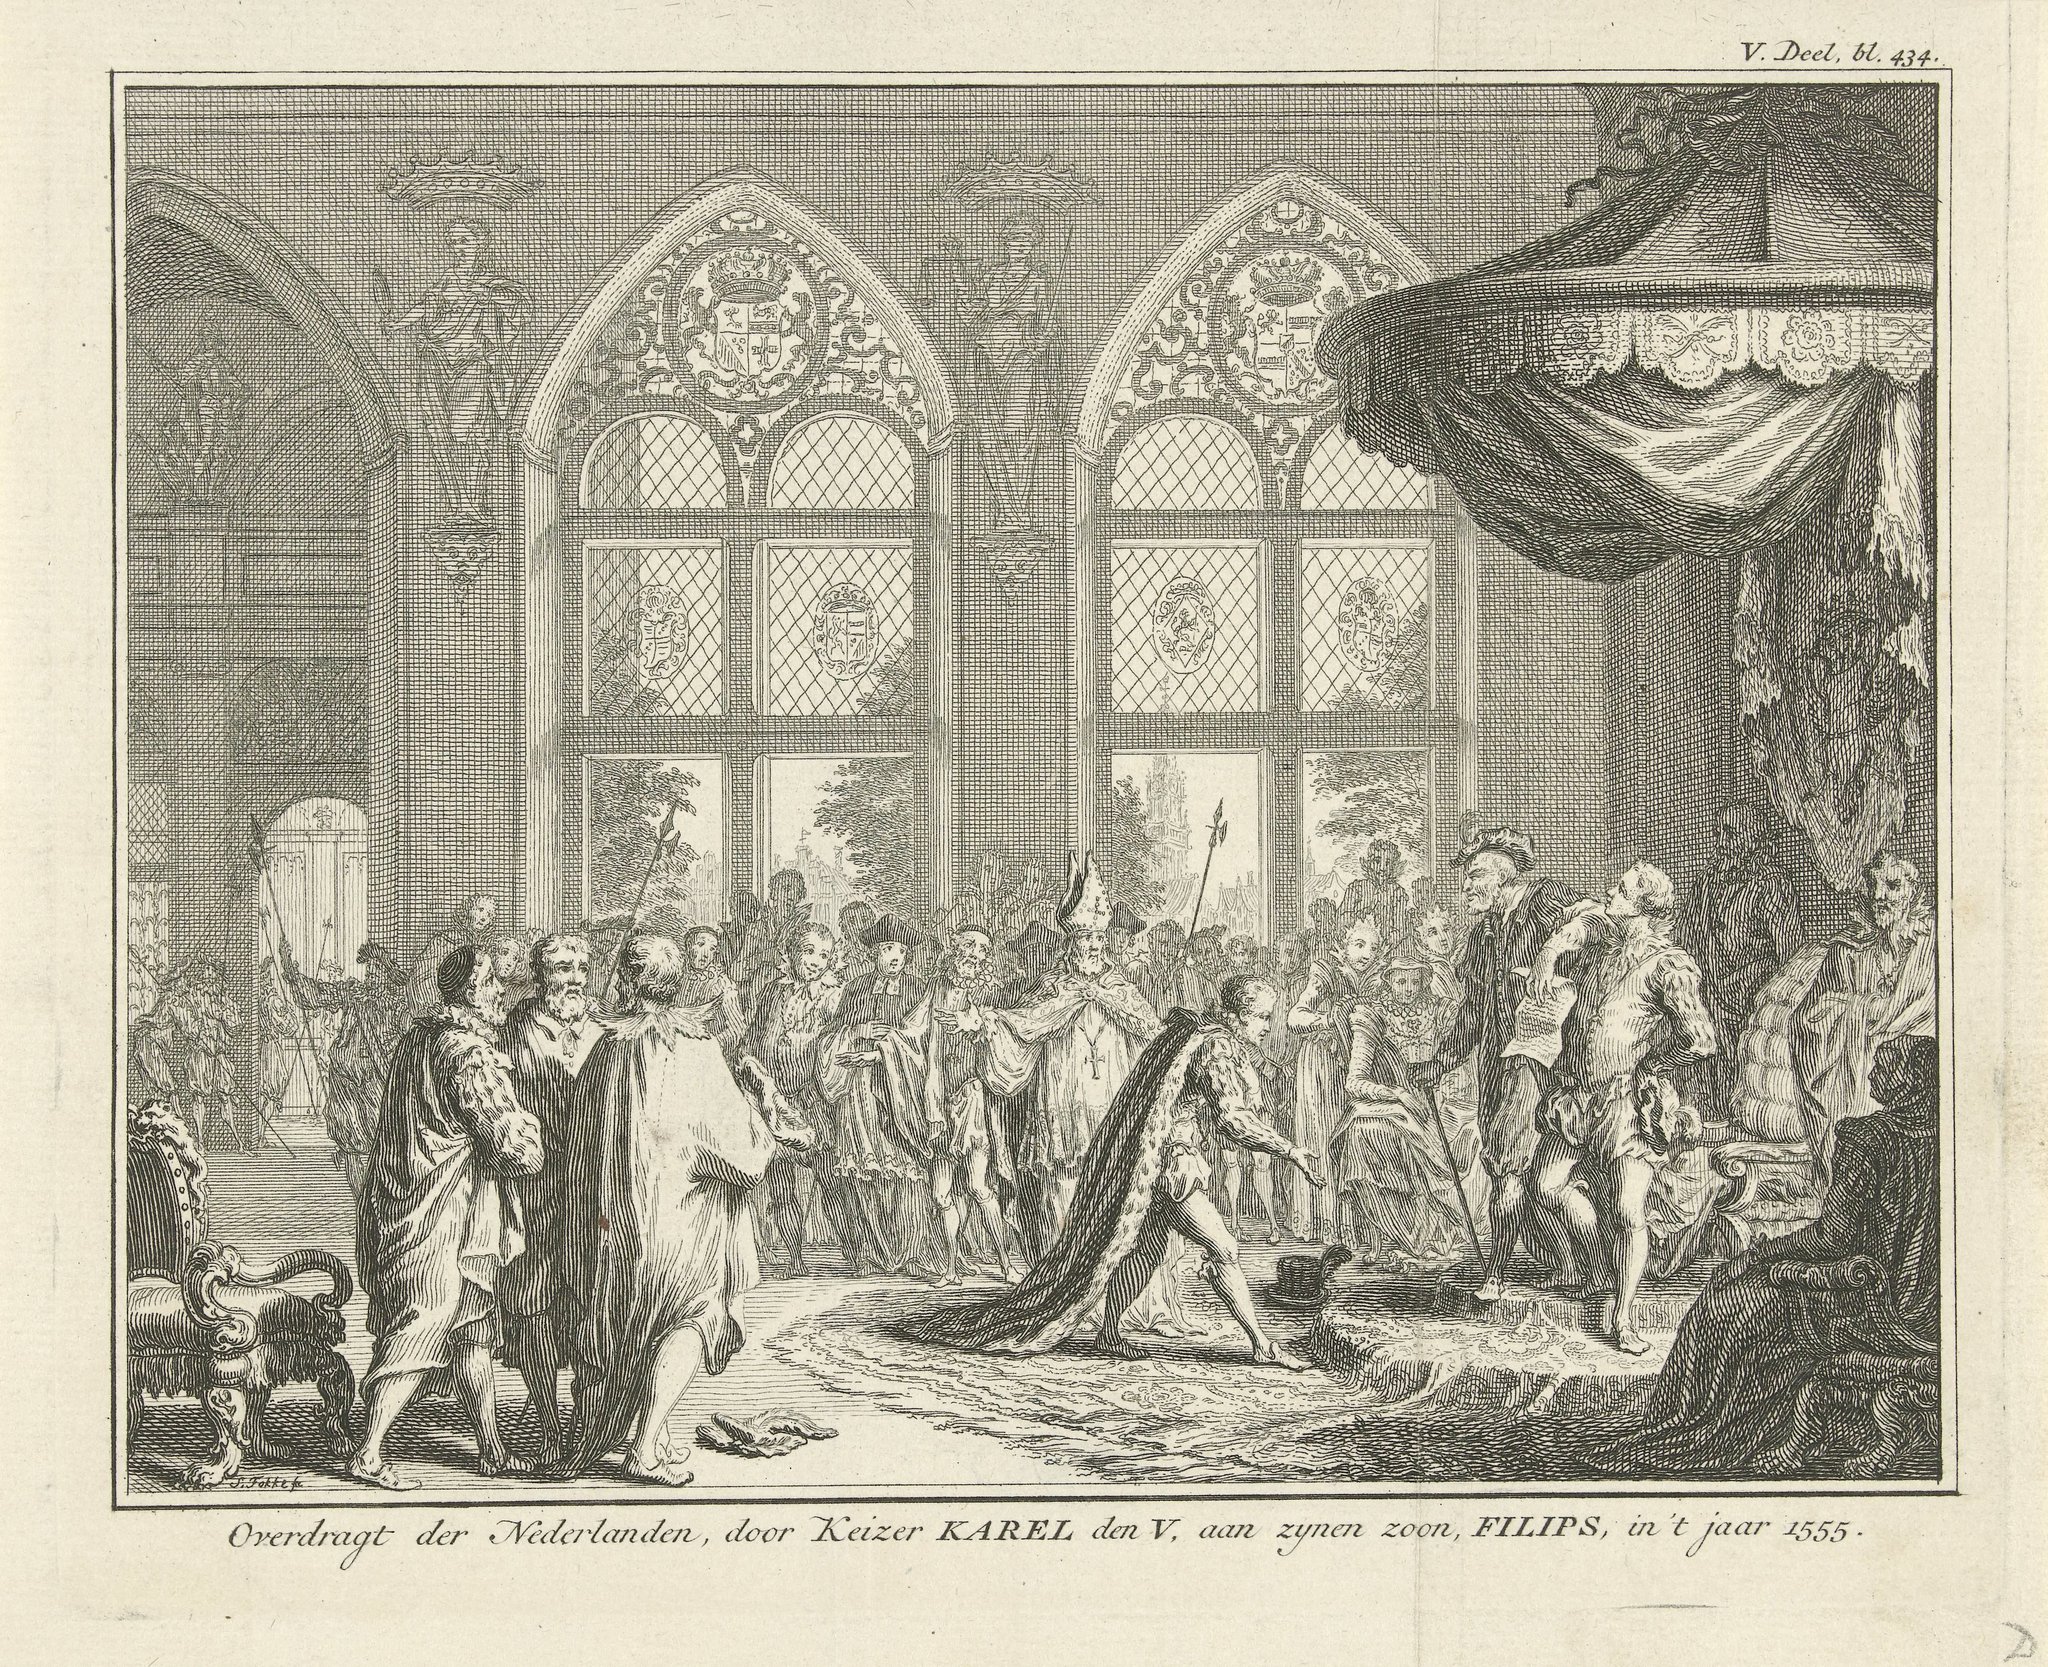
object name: print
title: Overdragt der Nederlanden, door Keizer Karel den V, aan zynen zoon, Filips, in 't jaar 1555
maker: simon fokke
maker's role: draughtsman, print maker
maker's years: 1712-1784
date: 1722-1784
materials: paper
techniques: etching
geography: amsterdam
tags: philip ii of spain, ghent, charles v (holy roman emperor and king of spain), voluntary abdication (of a ruler), brussels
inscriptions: collector's mark: Lugt 2228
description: Filips II maakt een buiging voor Karel V, die op een verhoging staat. Karel V leunt met zijn elleboog op de schouder van Prins Willem van Oranje. Omstanders in de zaal wonen de overdracht van de regering bij. Prent rechtsboven gemerkt: V. Deel, bl. 434.